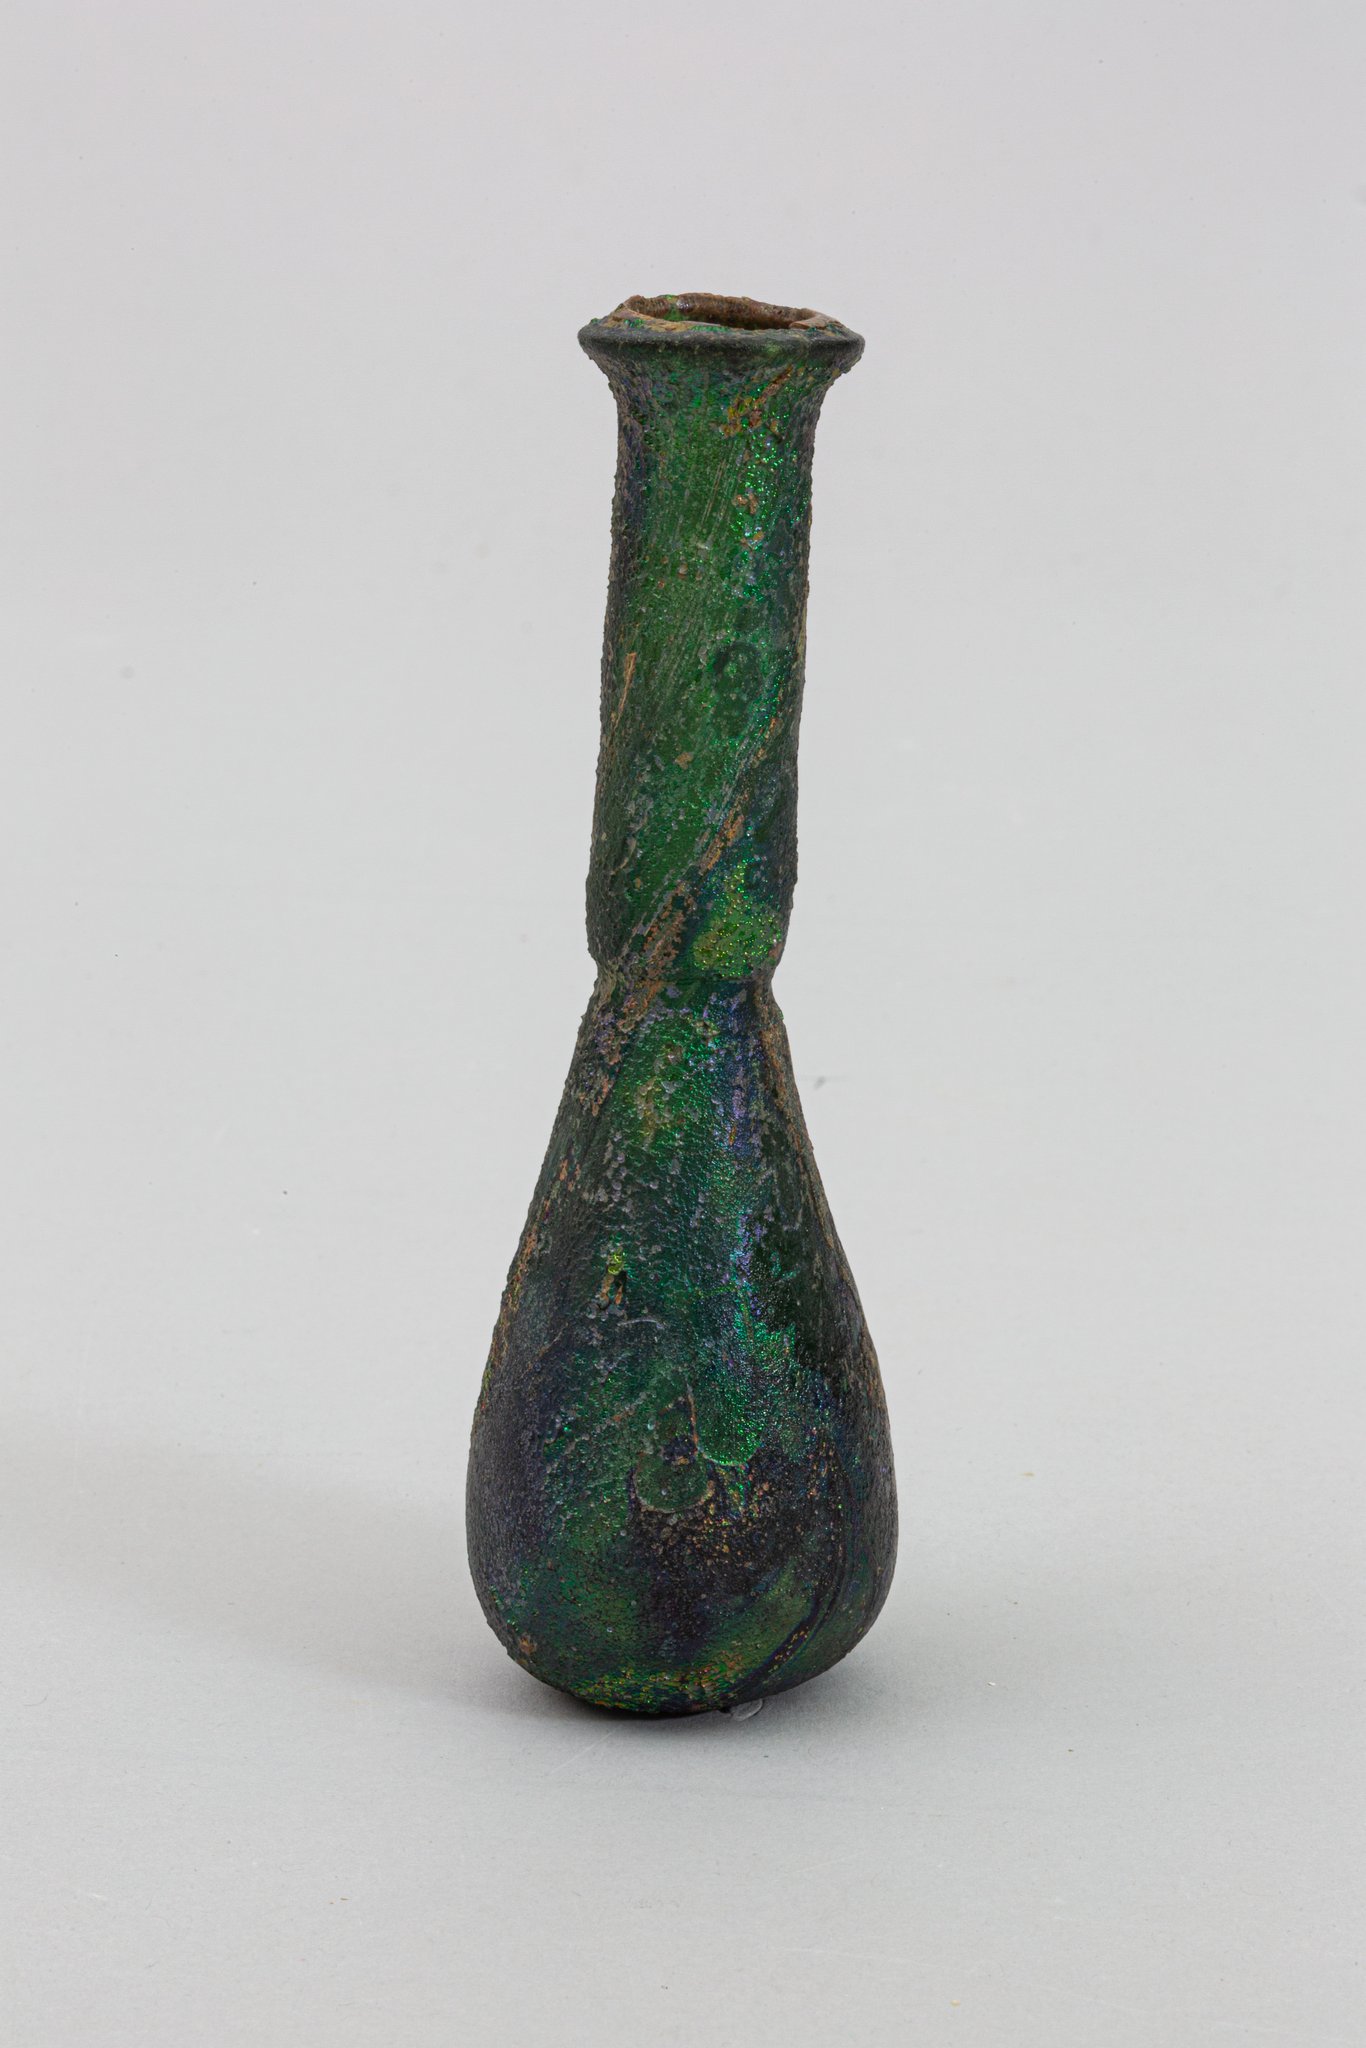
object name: bottle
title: Glass perfume bottle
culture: roman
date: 67-200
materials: glass